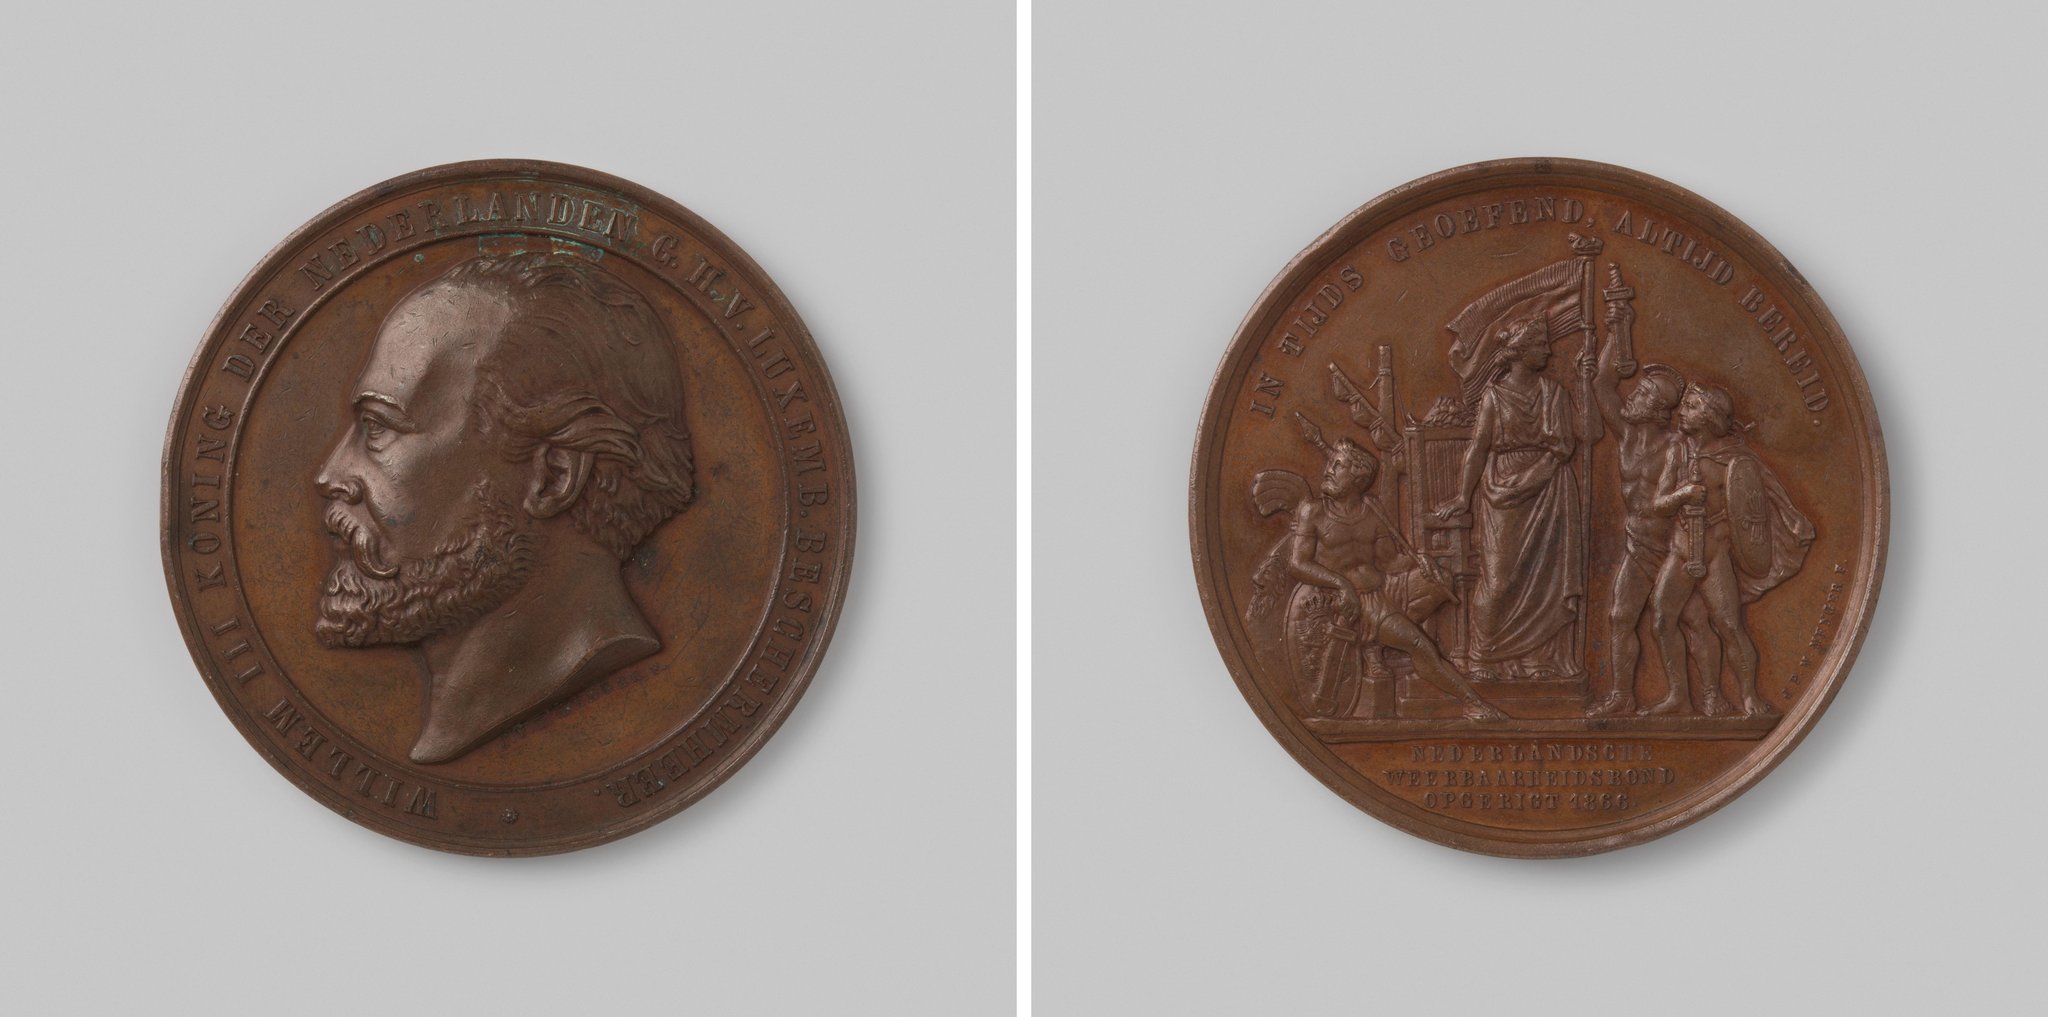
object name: history medal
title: Oprichting van de Nederlandsche Weerbaarheidsbond 1866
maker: johan philip mathias menger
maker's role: medailleur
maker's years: 1845-1905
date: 1866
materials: bronze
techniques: striking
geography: utrecht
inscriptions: factory mark: ‘mercuriusstaf’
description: Bronzen penning, op de voorzijde het portret van Koning Willem III naar links met omschrift, op de keerzijde de Nederlandse Maagd met vaandel voor haar troon, te midden van antiek geklede krijgers, met bovenaan omschrift en afsnedetekst.